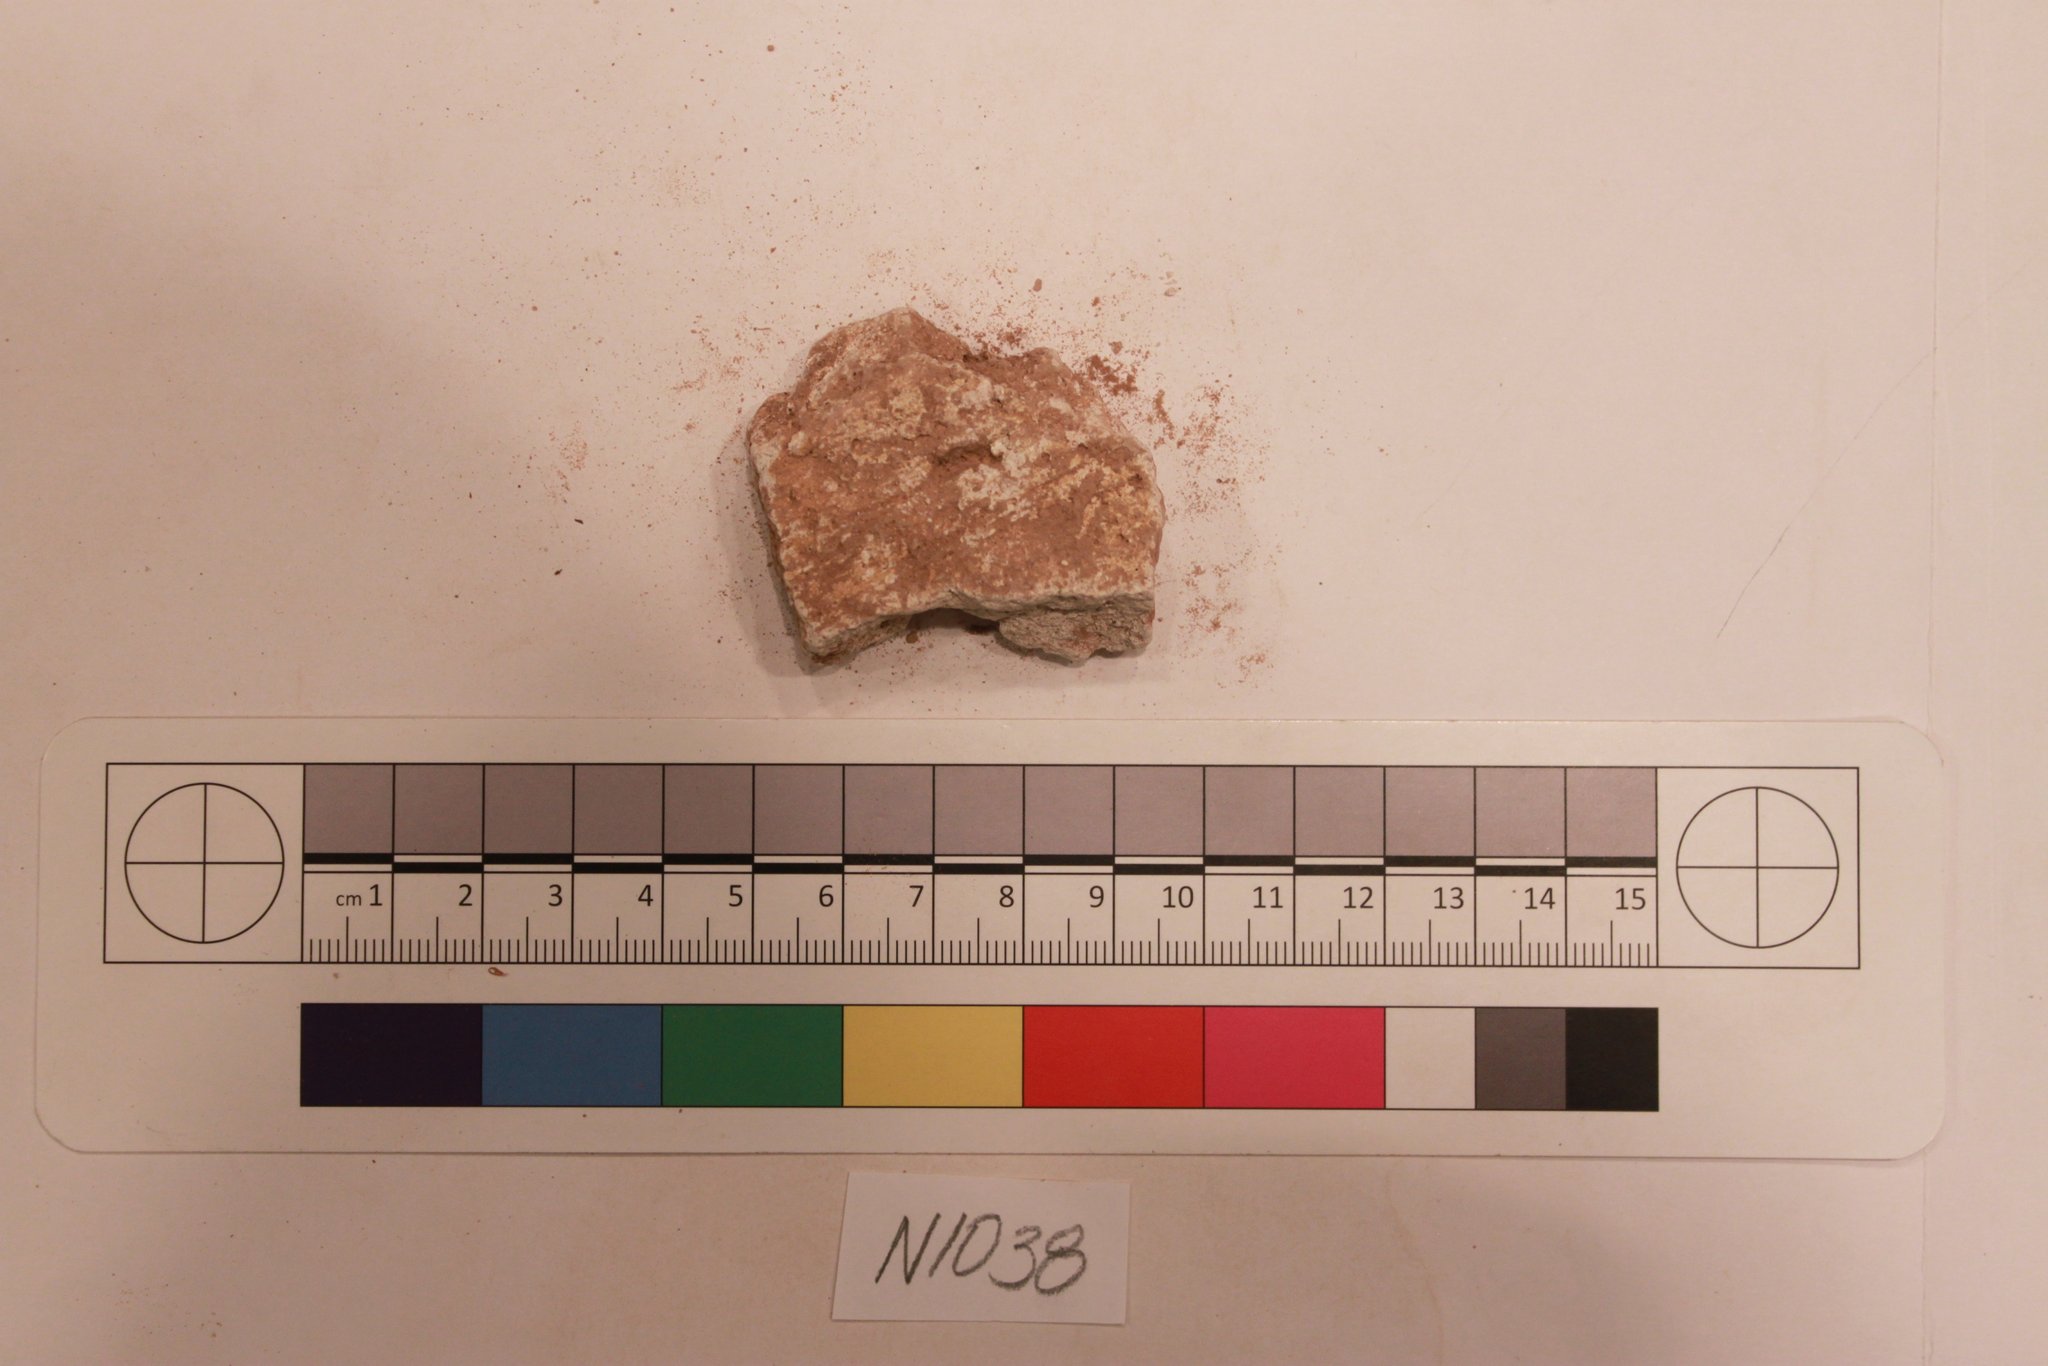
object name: fragment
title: Stucco Fragment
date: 701-1200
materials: plaster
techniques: carving, painting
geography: iran